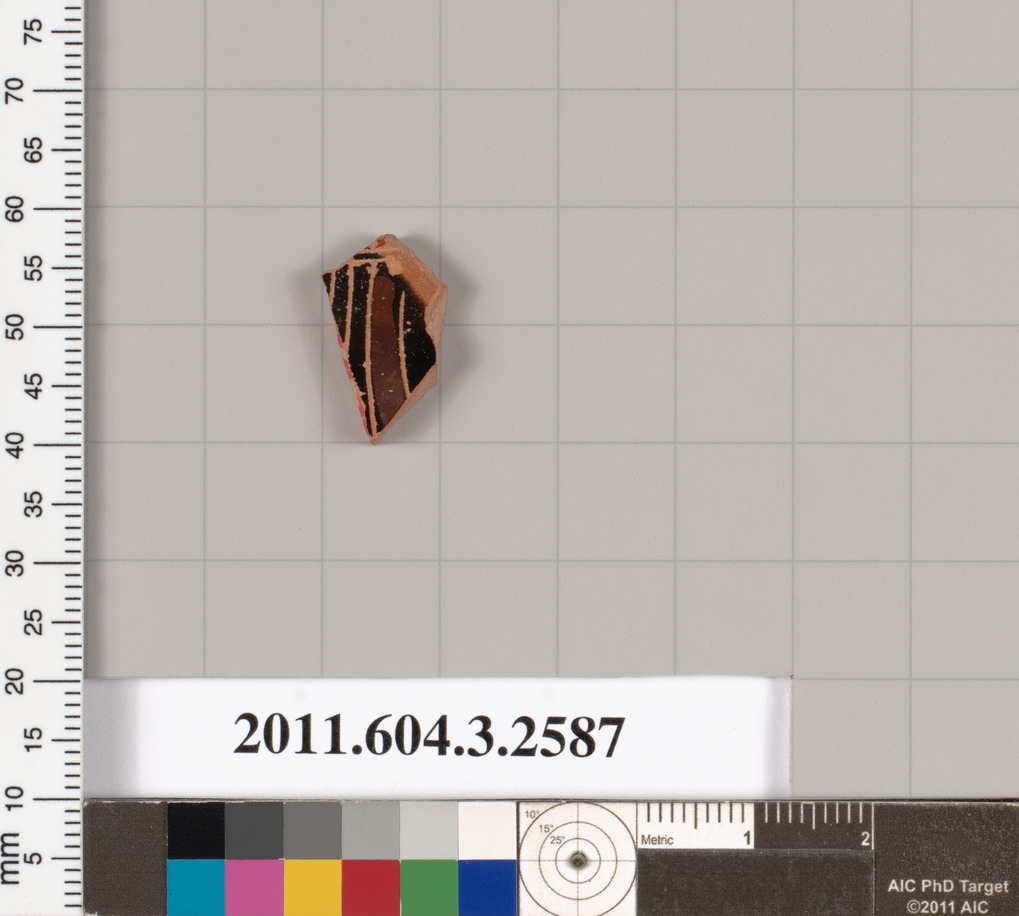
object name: kylix fragment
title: Terracotta fragment of a Little Master cup (drinking cup)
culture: greek, attic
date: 575-551 BCE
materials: terracotta